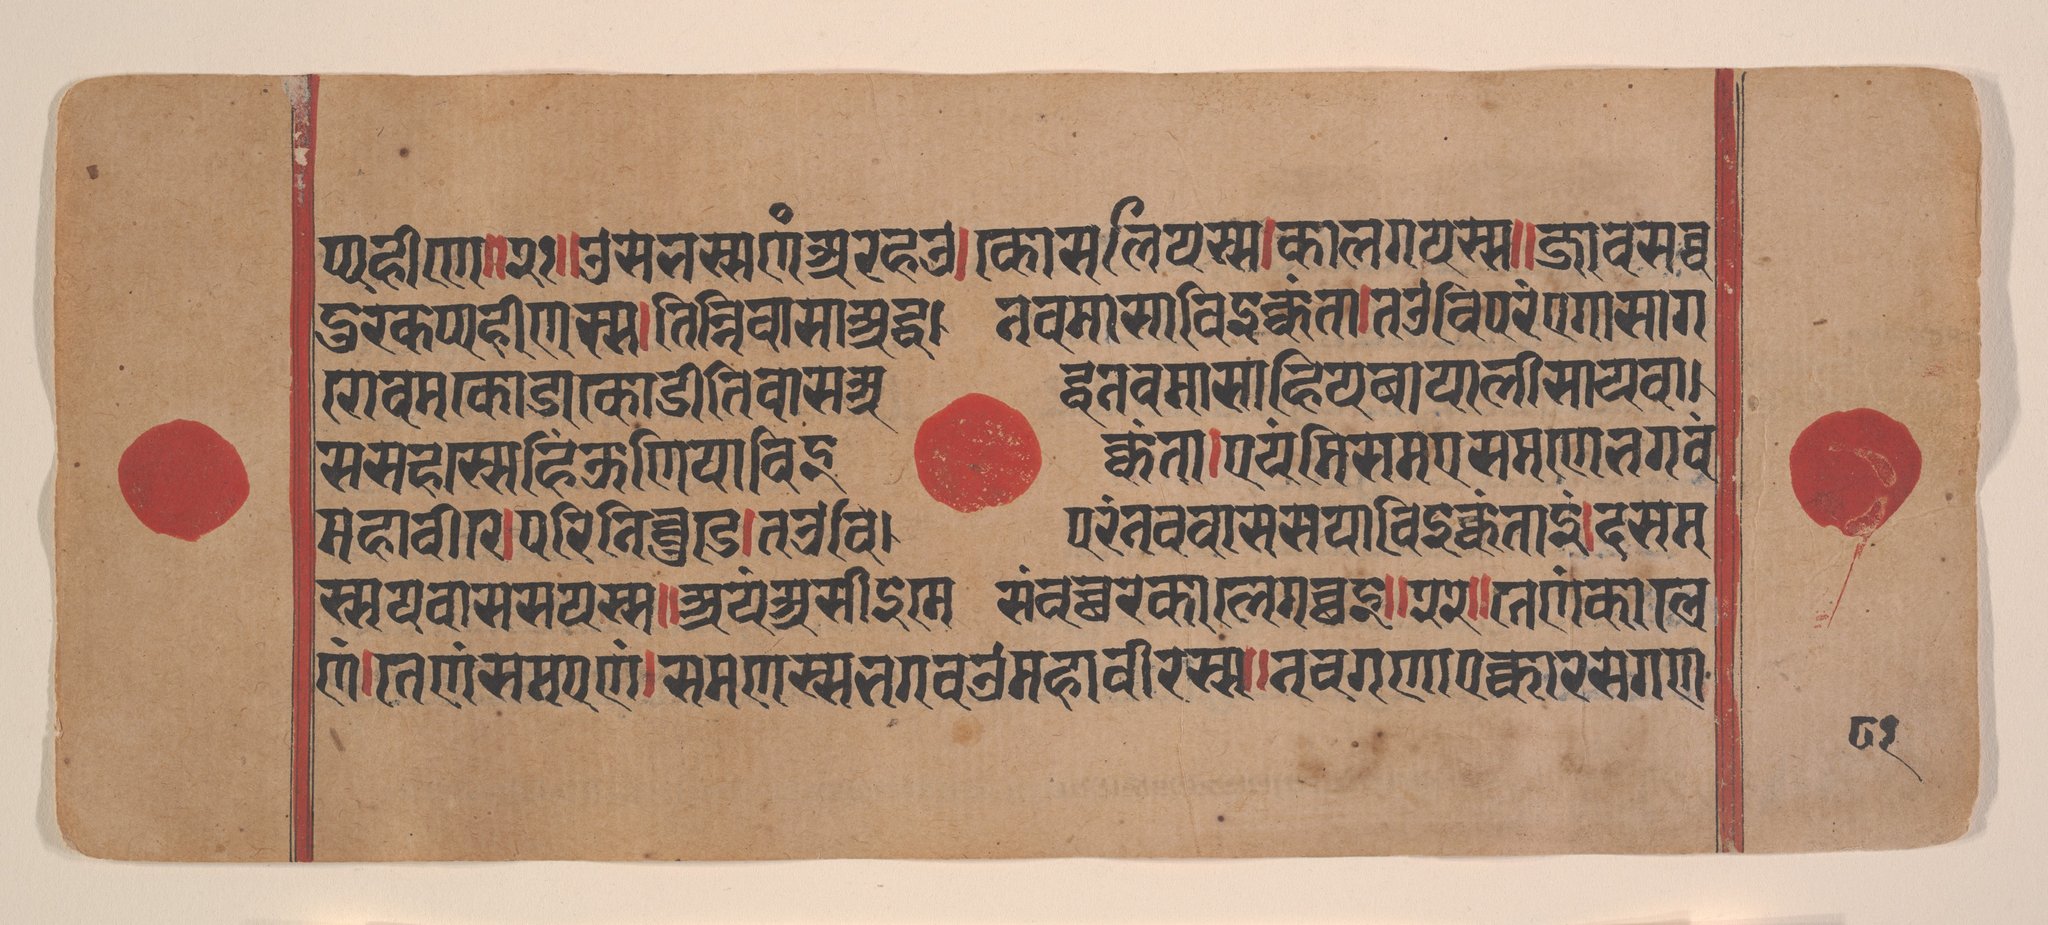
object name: folio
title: Page from a Dispersed Kalpa Sutra (Jain Book of Rituals)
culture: indian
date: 1401-1500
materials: gold, ink, paper, watercolor